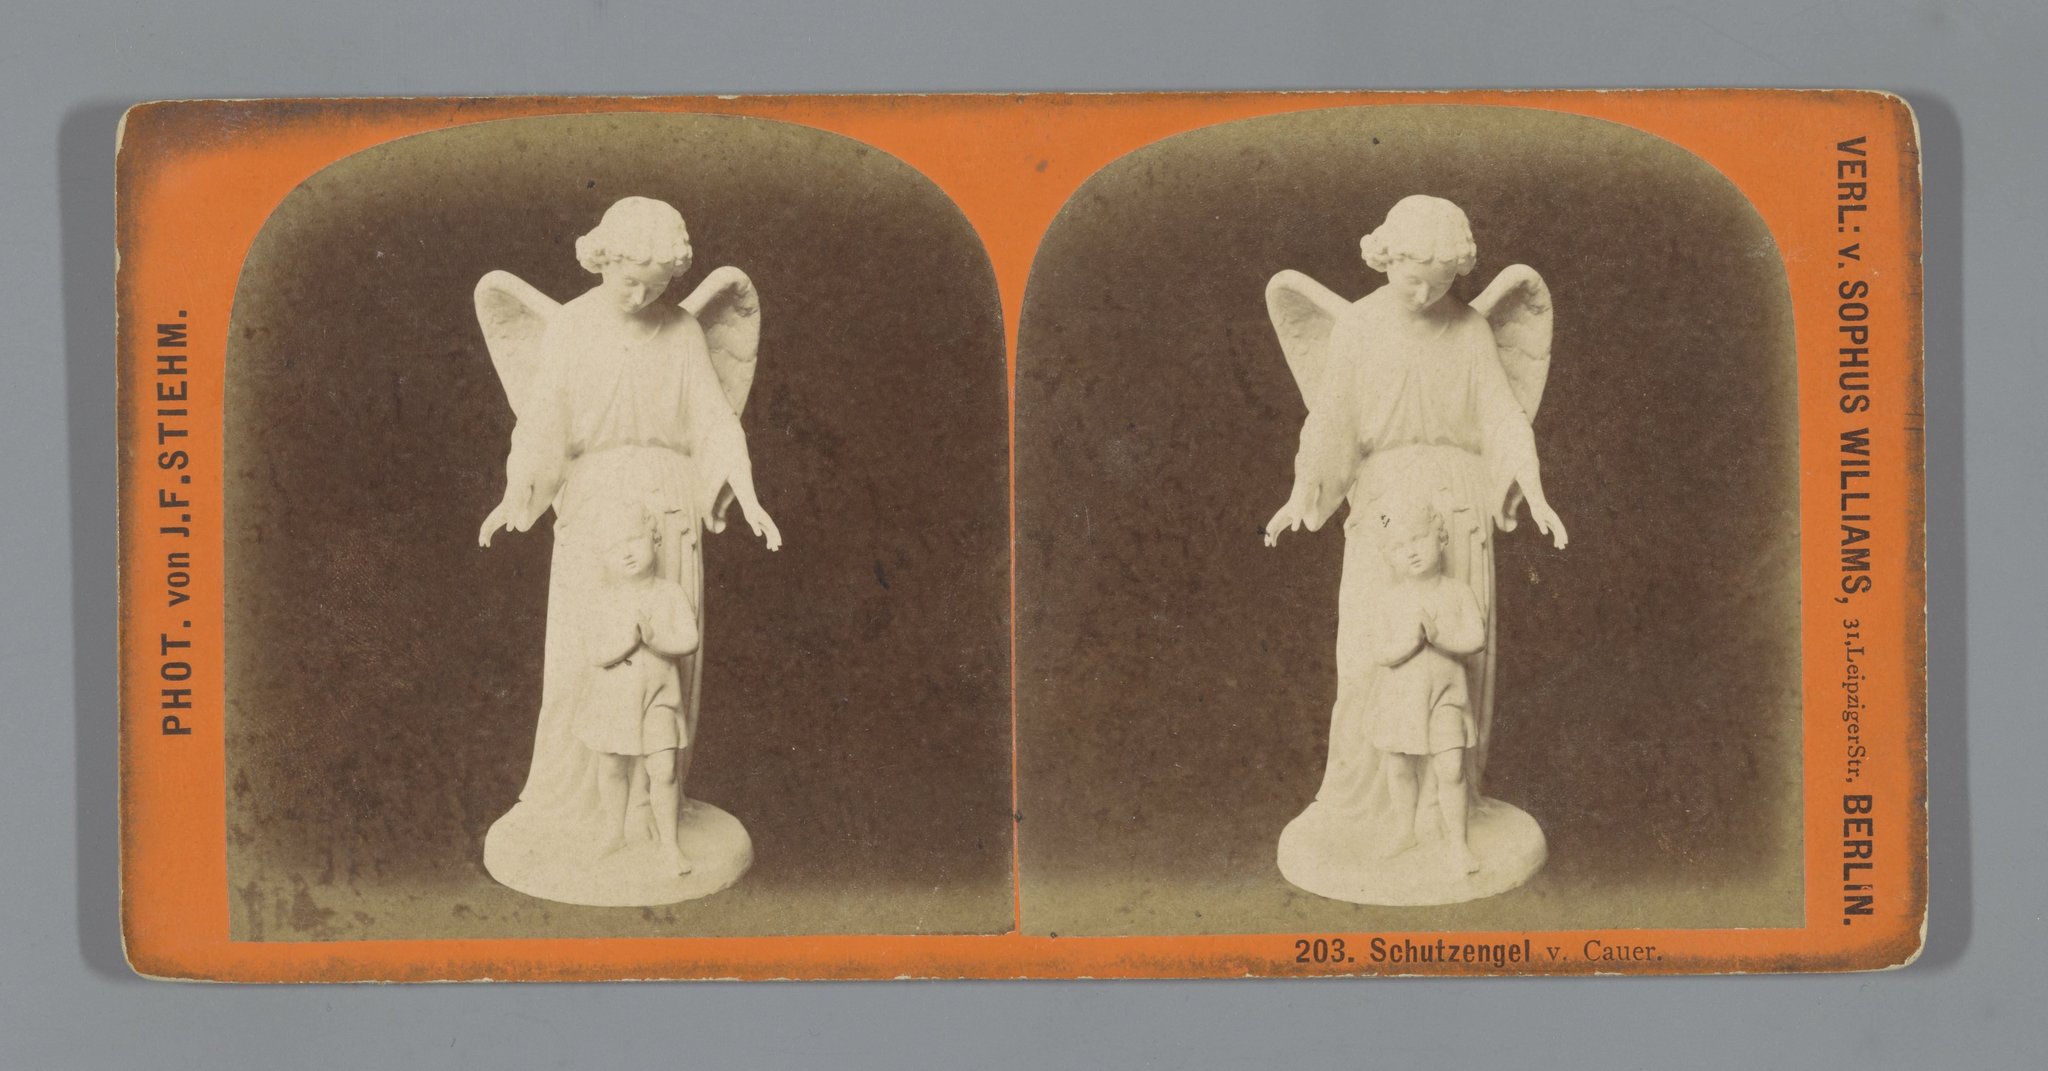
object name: stereograph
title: Schutzengel v. Cauer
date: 1855-1890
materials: cardboard, photographic support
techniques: albumen print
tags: sculptor, guardian angel, sculpture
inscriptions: : ‘31. Leipziger Str. Berlin’, number: ‘203’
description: Sculptuur van de Duitse beeldhouwer Robert Cauer.